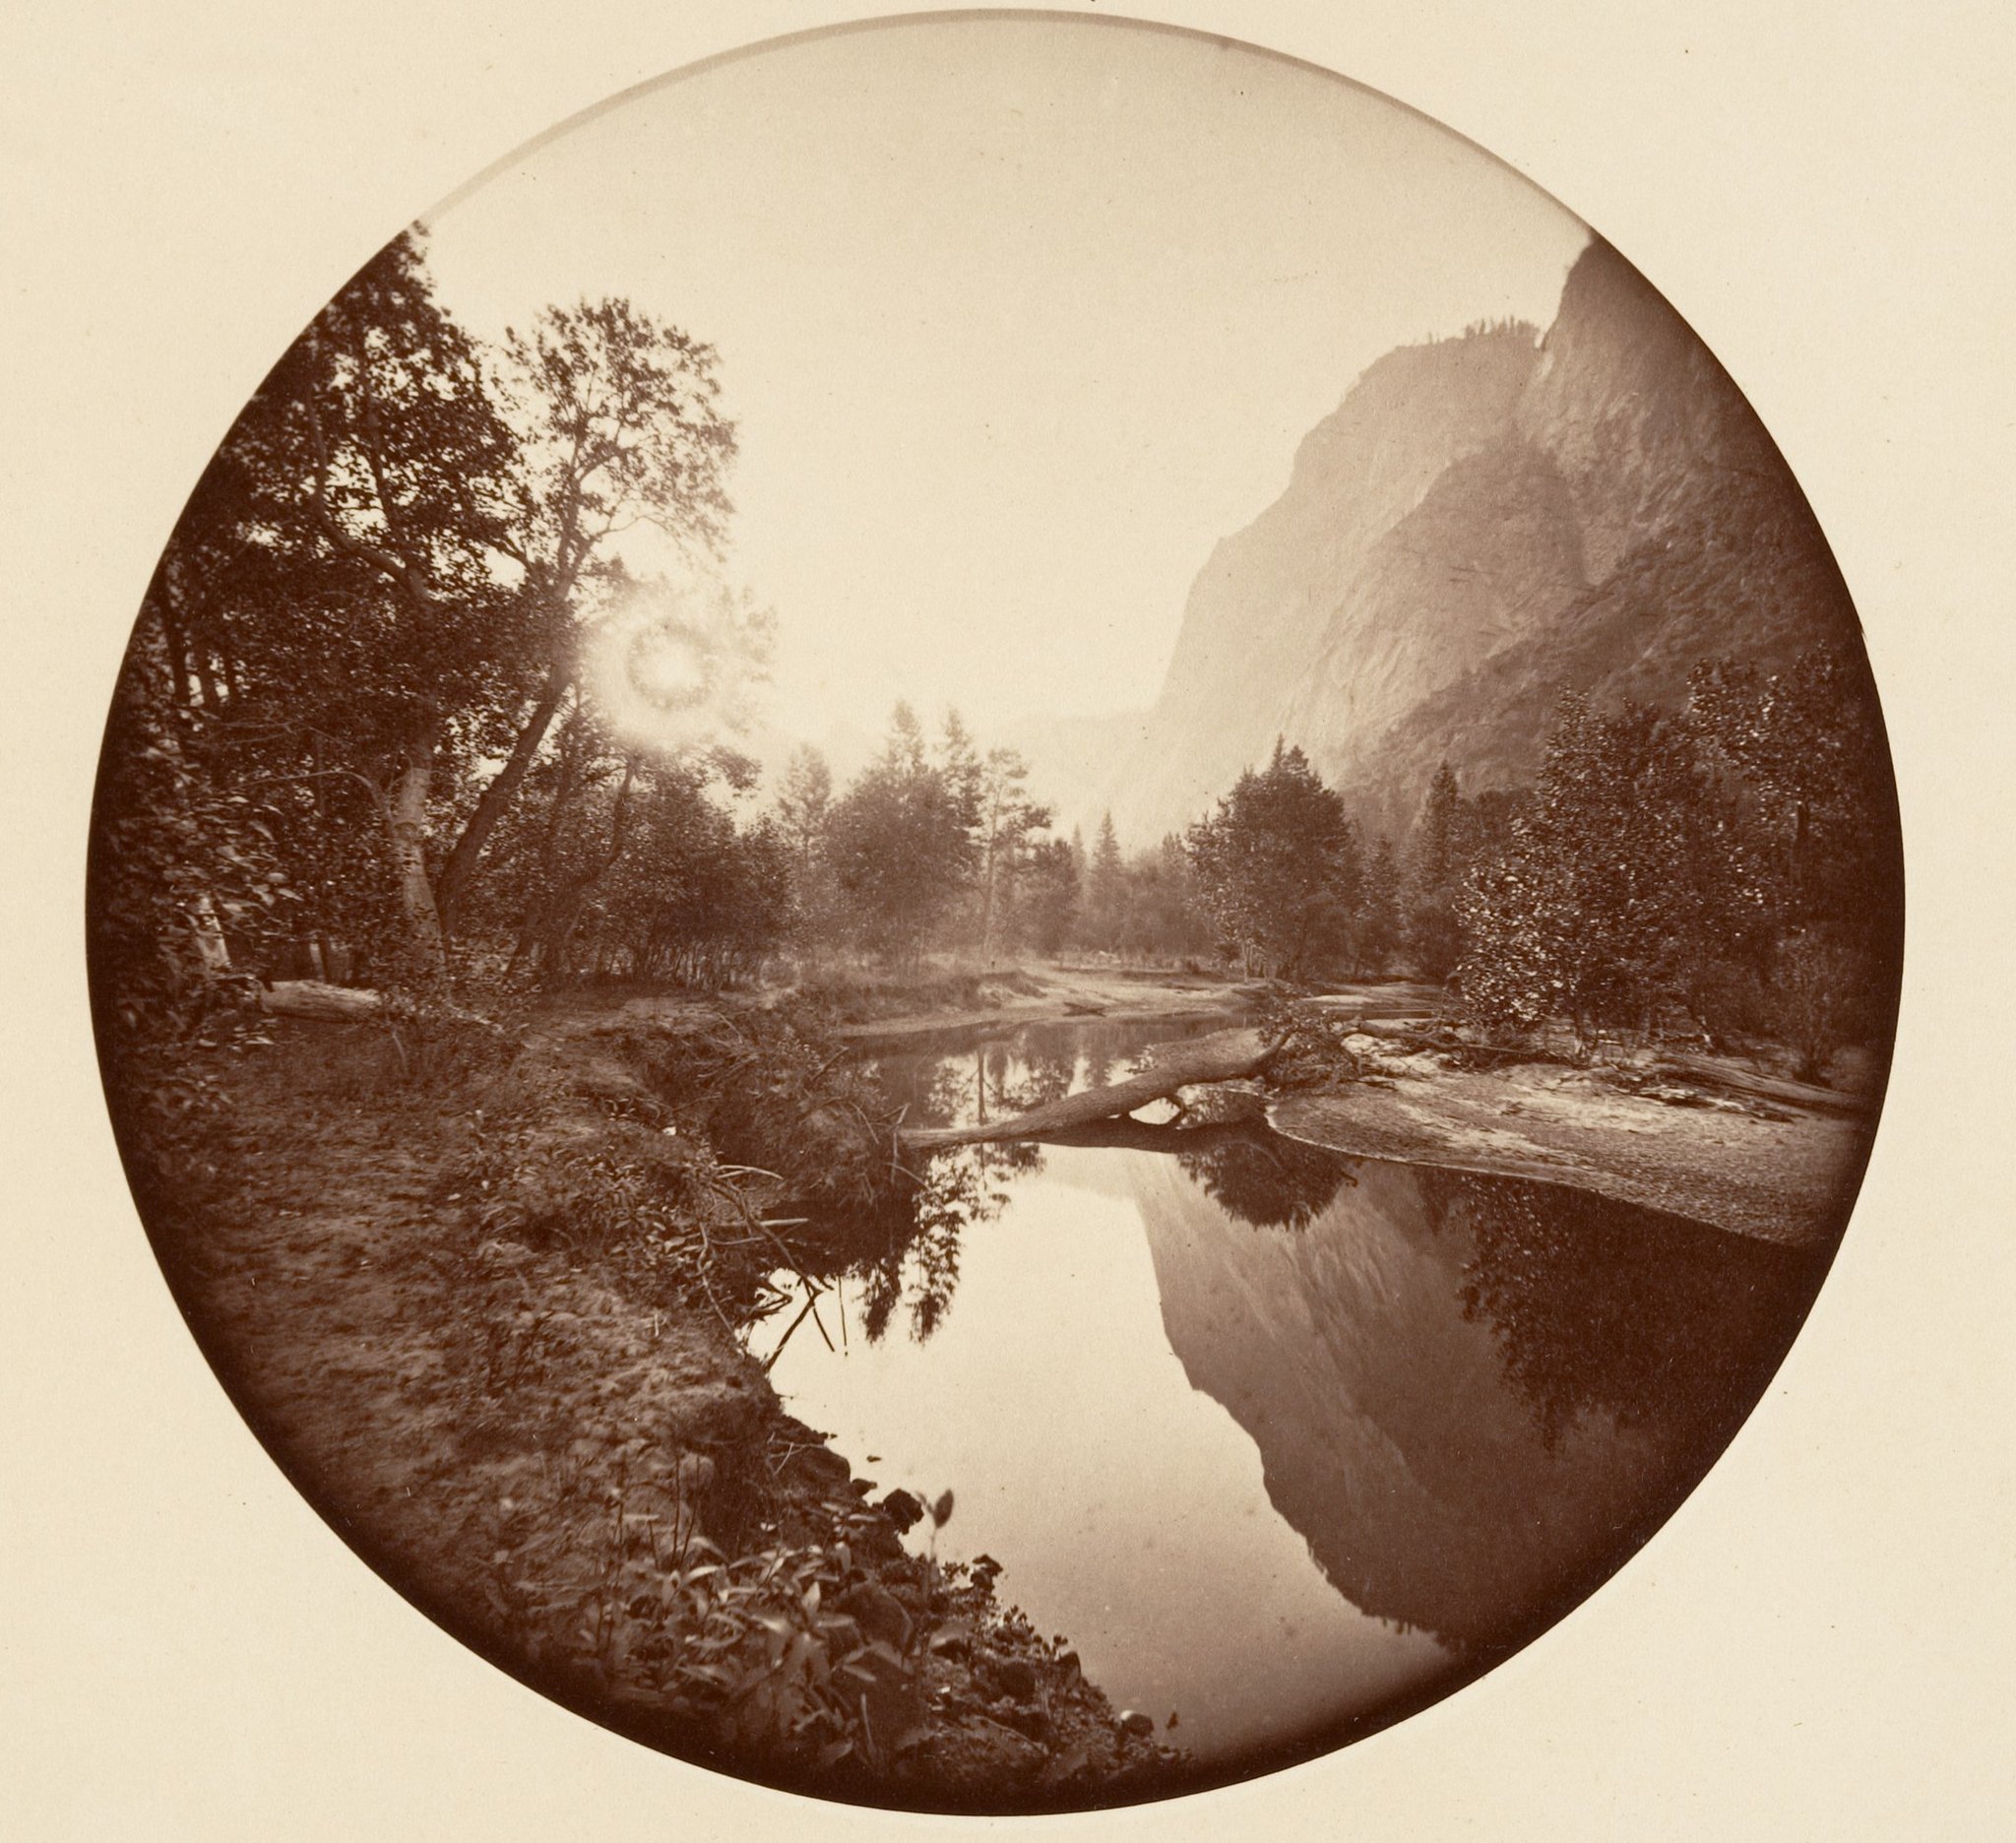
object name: photograph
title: [Yosemite National Park, California]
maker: carleton e. watkins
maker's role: artist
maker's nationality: american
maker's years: 1829-1916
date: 1878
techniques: albumen silver print, glass negative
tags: landscapes,streams